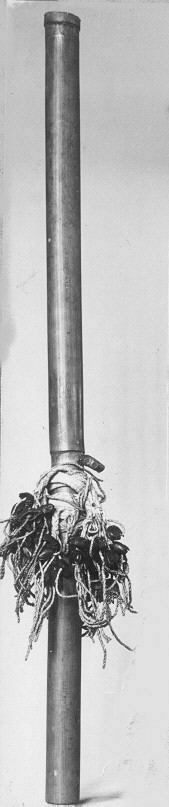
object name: stamping tube or rattle staff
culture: native american or guyanese or demerara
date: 1801-1900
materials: bamboo, cord, cotton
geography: guyana